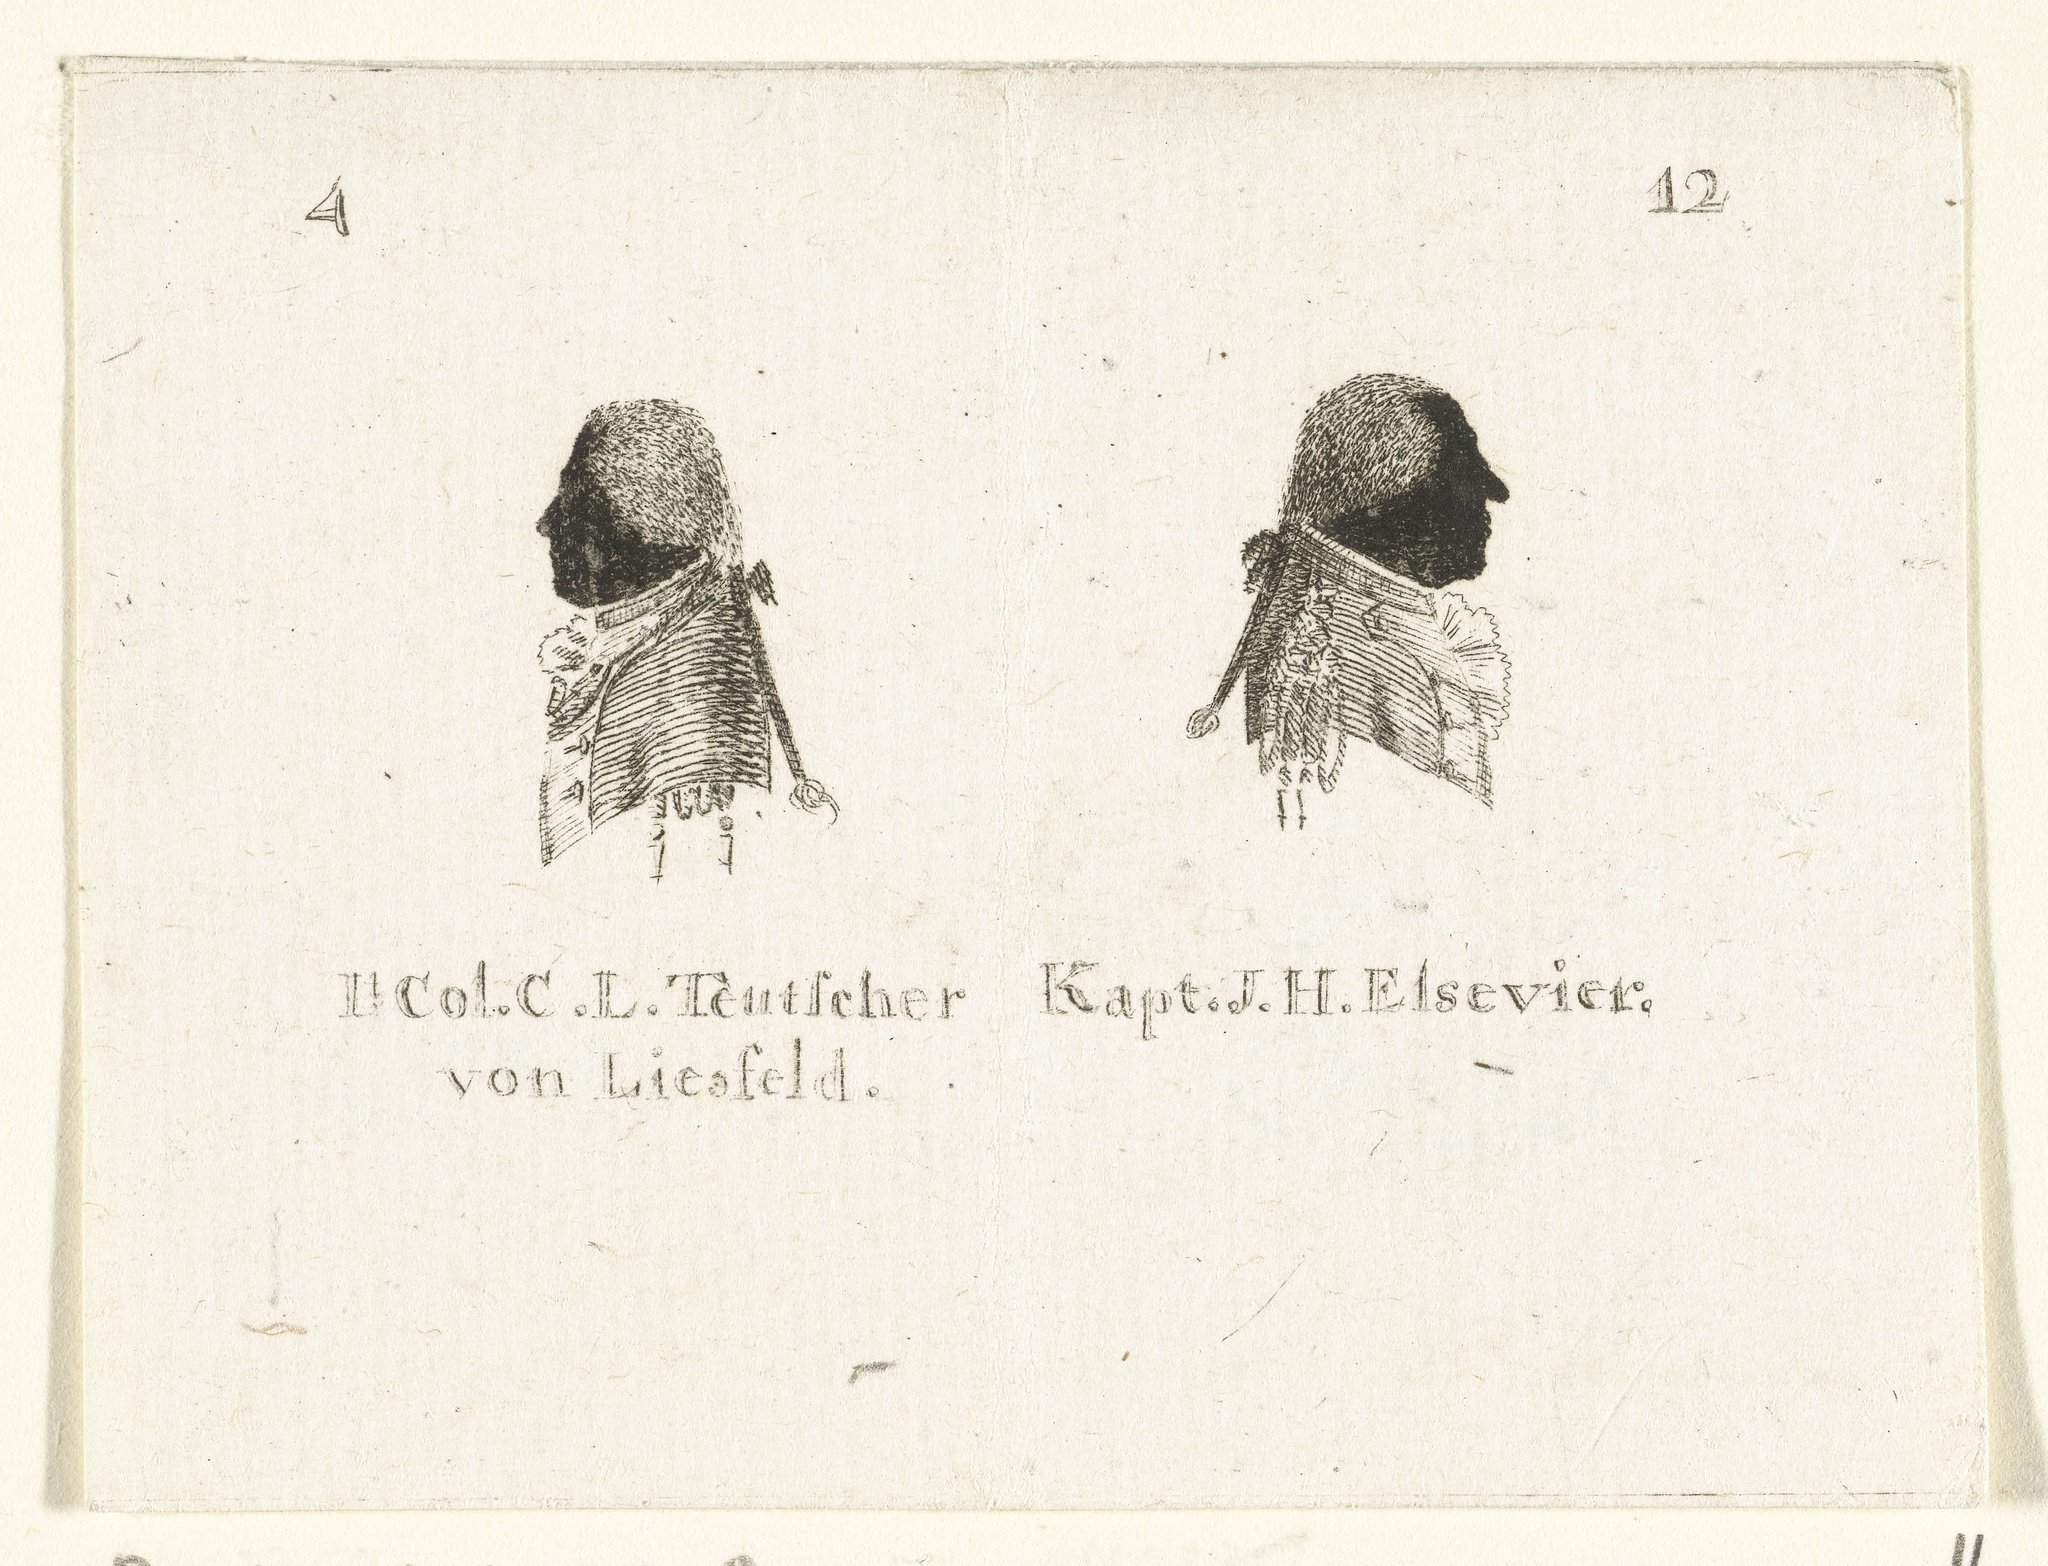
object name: book illustration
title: Zakboekje van de helden van de Willemstad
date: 1794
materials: paper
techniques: etching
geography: amsterdam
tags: c.l. teutscher von liesfeld, kapitein, j.h. elsevier, beleg van willemstad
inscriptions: collector's mark: Lugt 2228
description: Twee silhouetportretten uit een boekje over de soldaten die Willemstad hebben verdedigd in 1793. De linker is van kolonel C.L. Teutscher von Liesfeld met buste naar links. De rechter is van kapitein J.H. Elsevier met buste naar rechts. De prent heeft een onderschrift met de namen van de geportretteerde militairen.